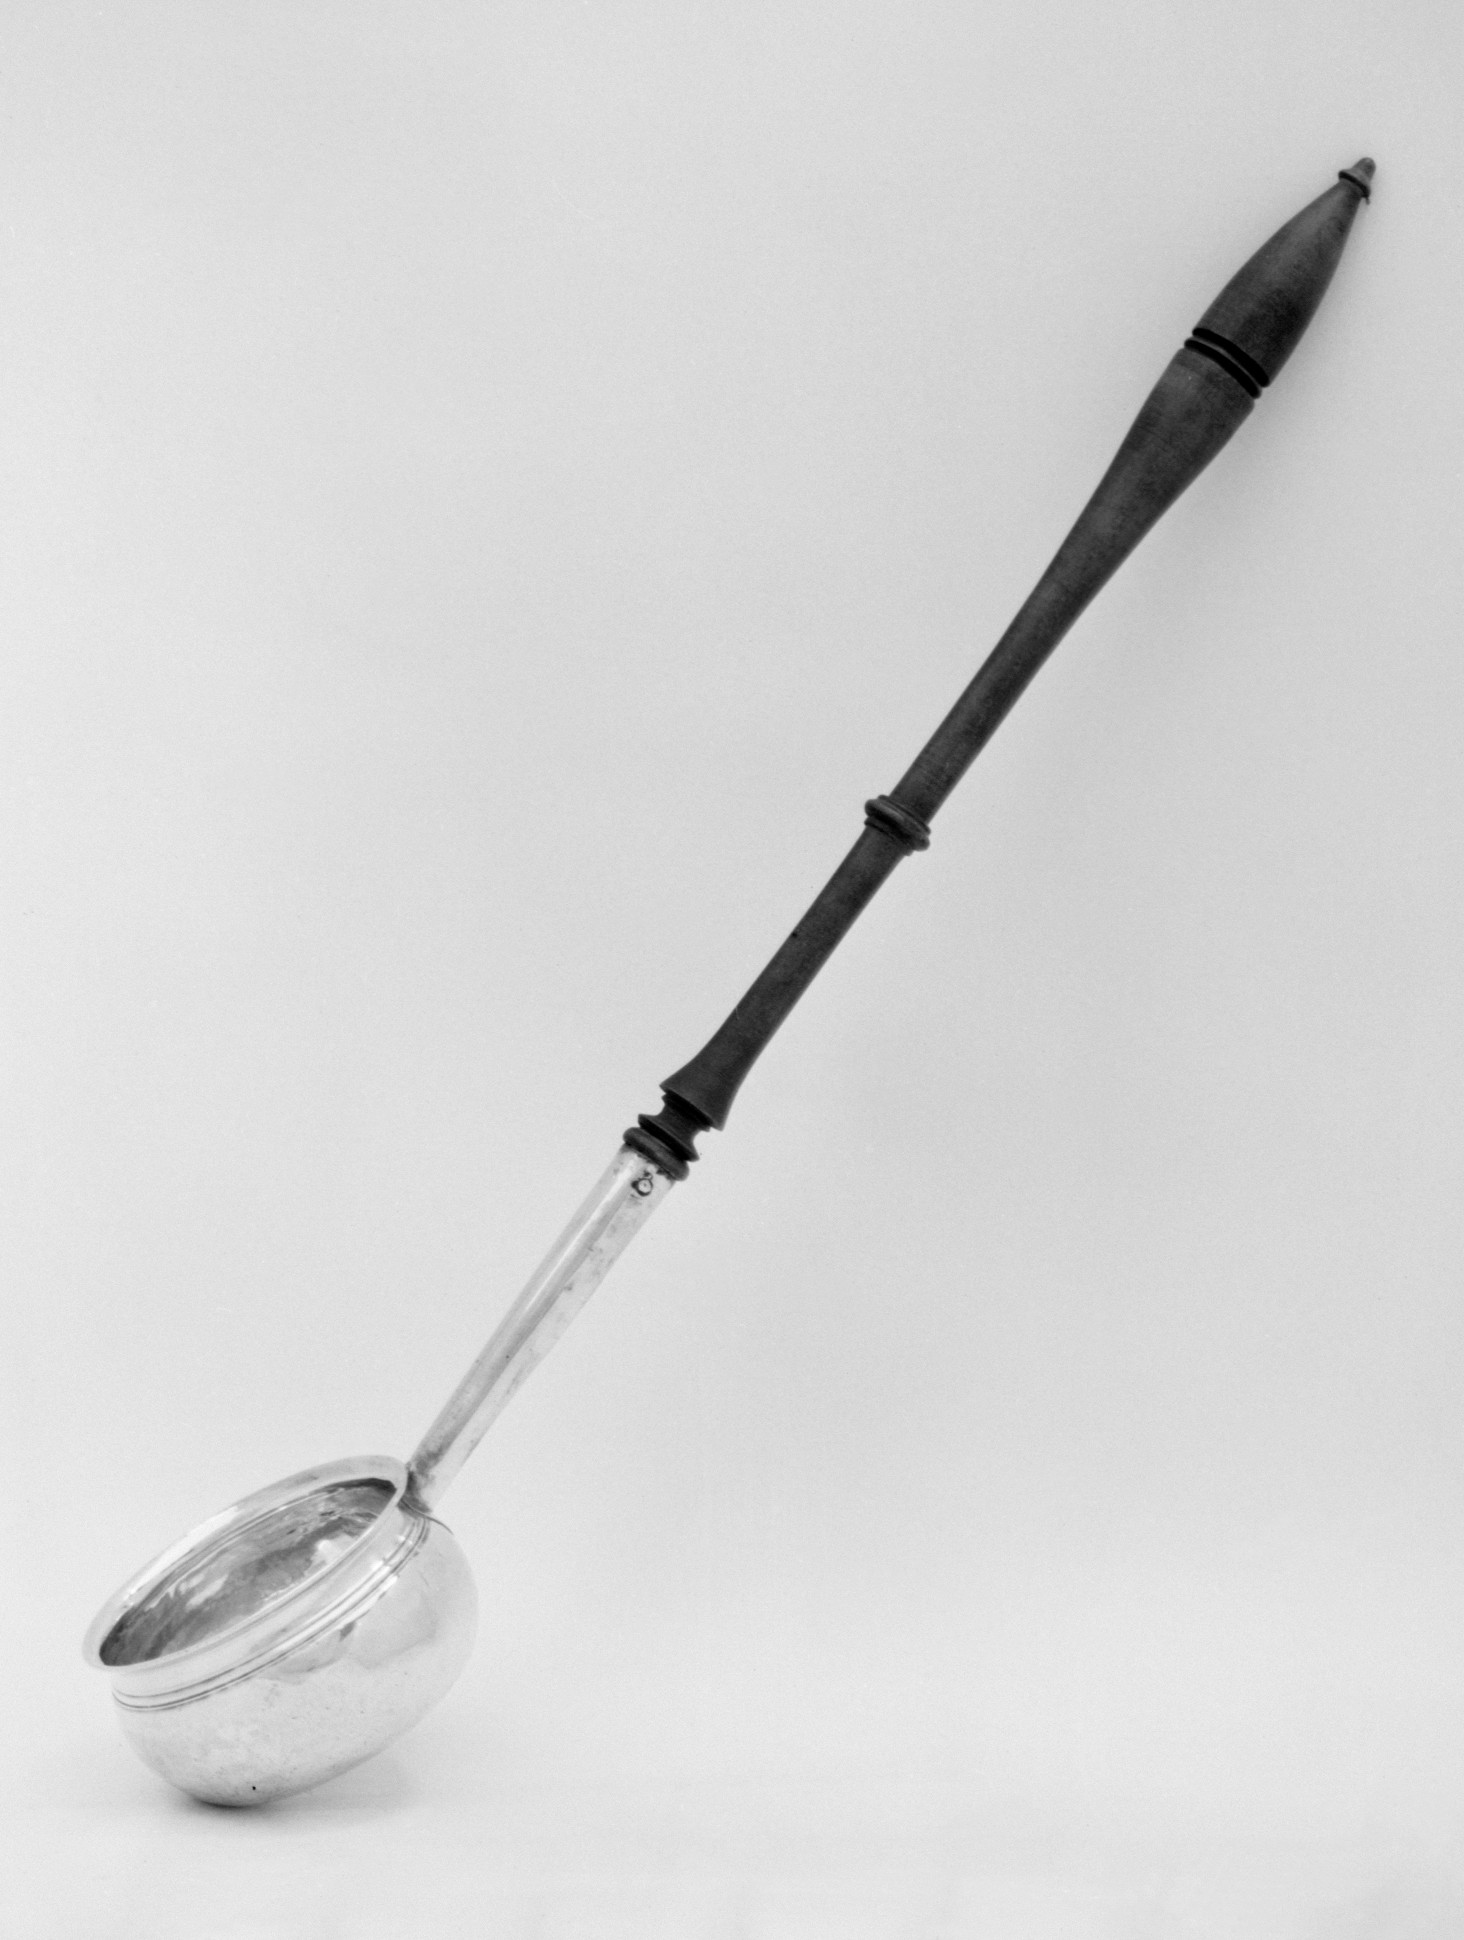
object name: toddy ladle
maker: henry jay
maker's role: maker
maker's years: 1638-1738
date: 1718-1719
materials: silver, wood